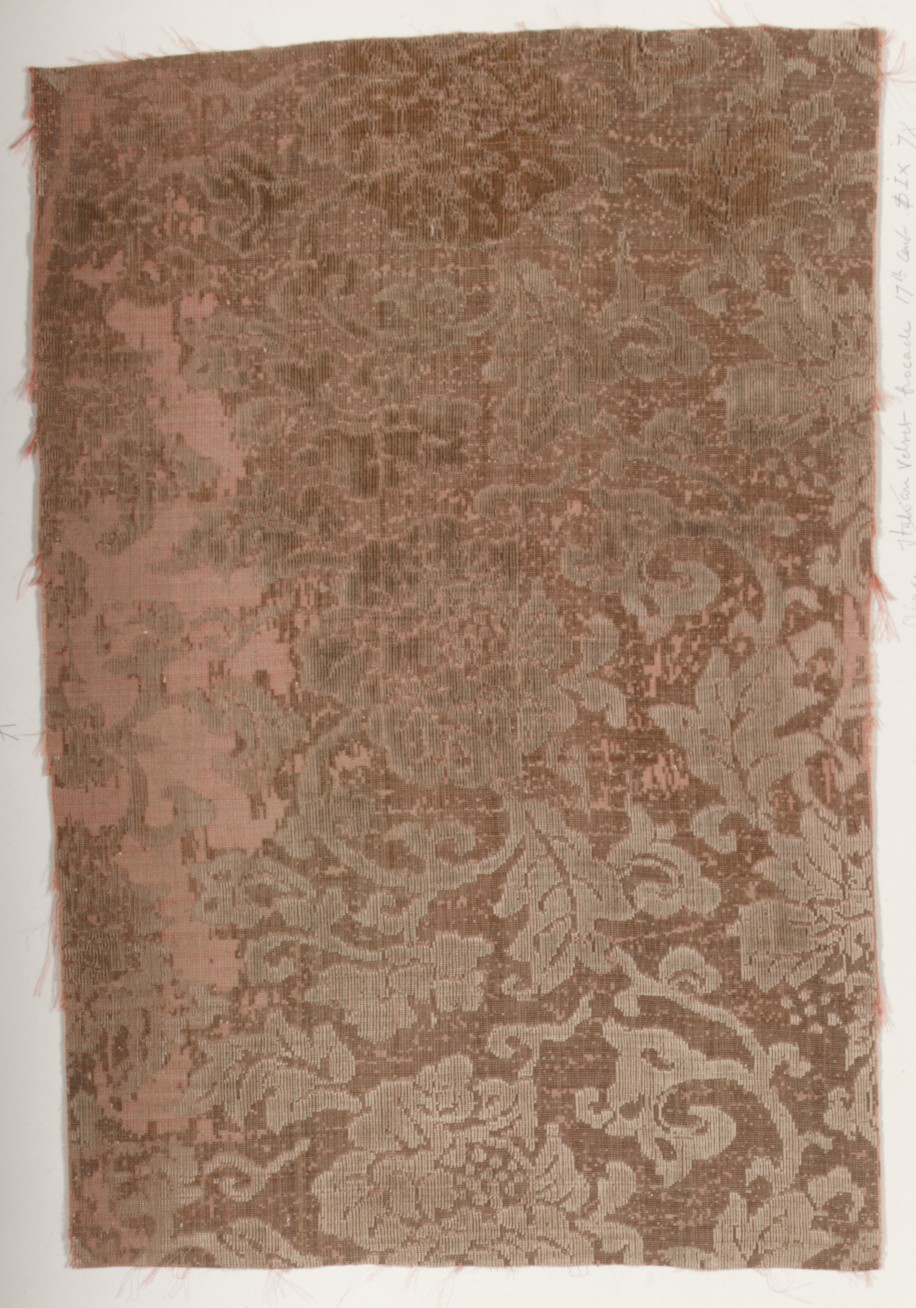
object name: fragment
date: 1601-1700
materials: metal thread, silk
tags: leaves